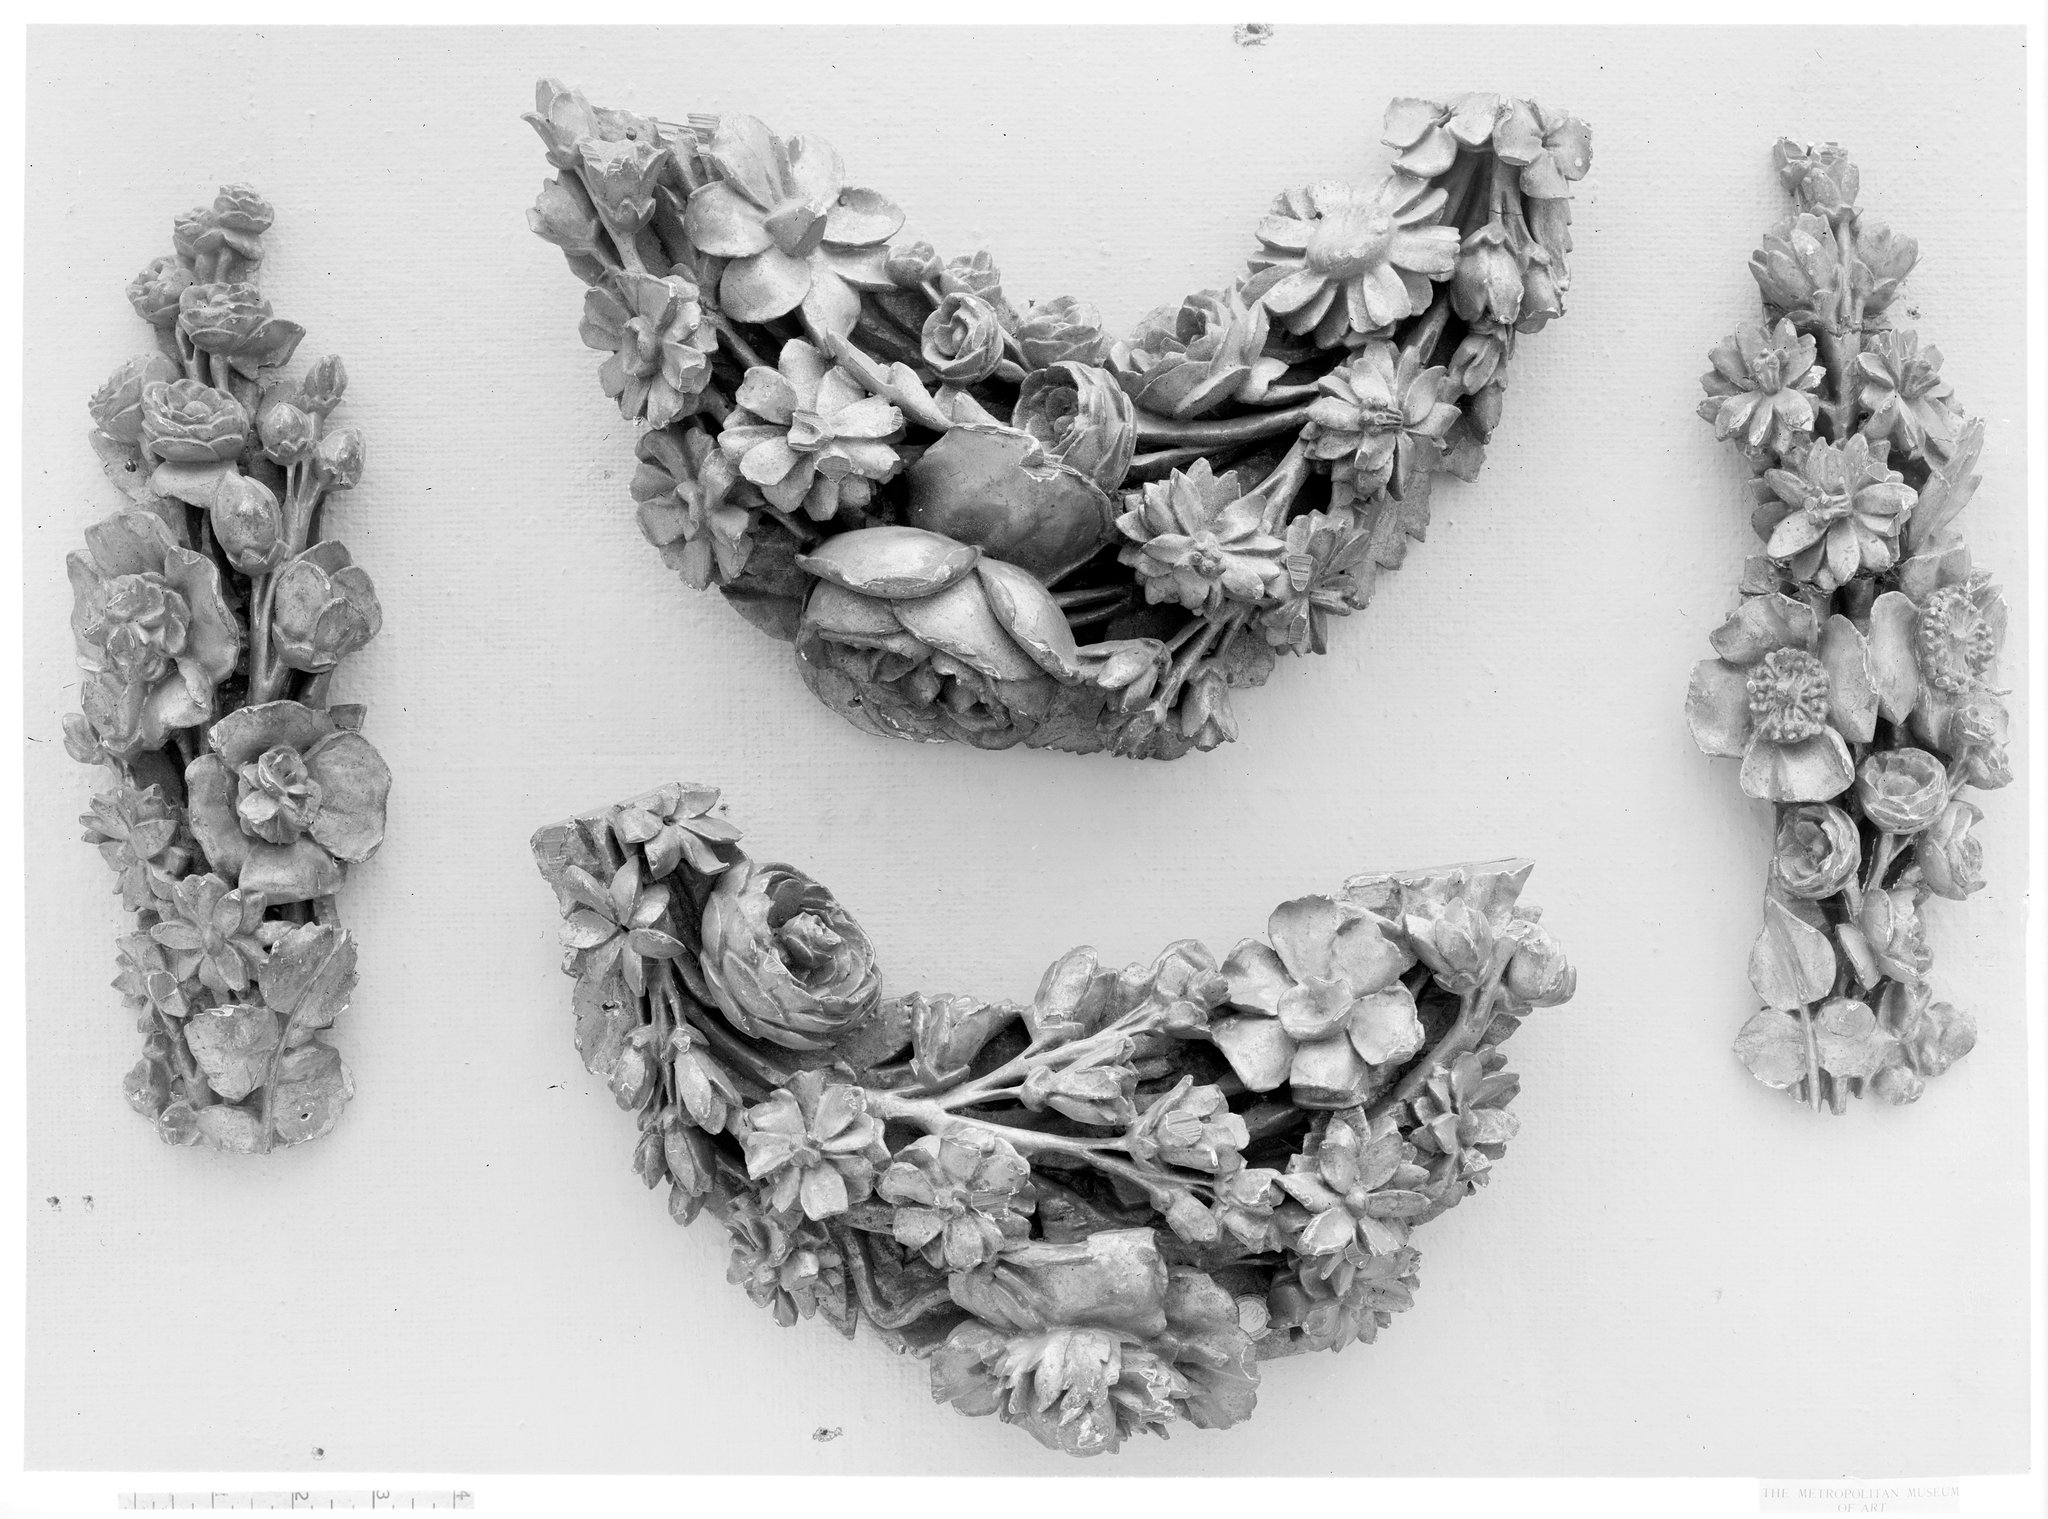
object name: garland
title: Garland (part of a set)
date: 1701-1800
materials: gilt, wood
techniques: carving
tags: garlands,flowers